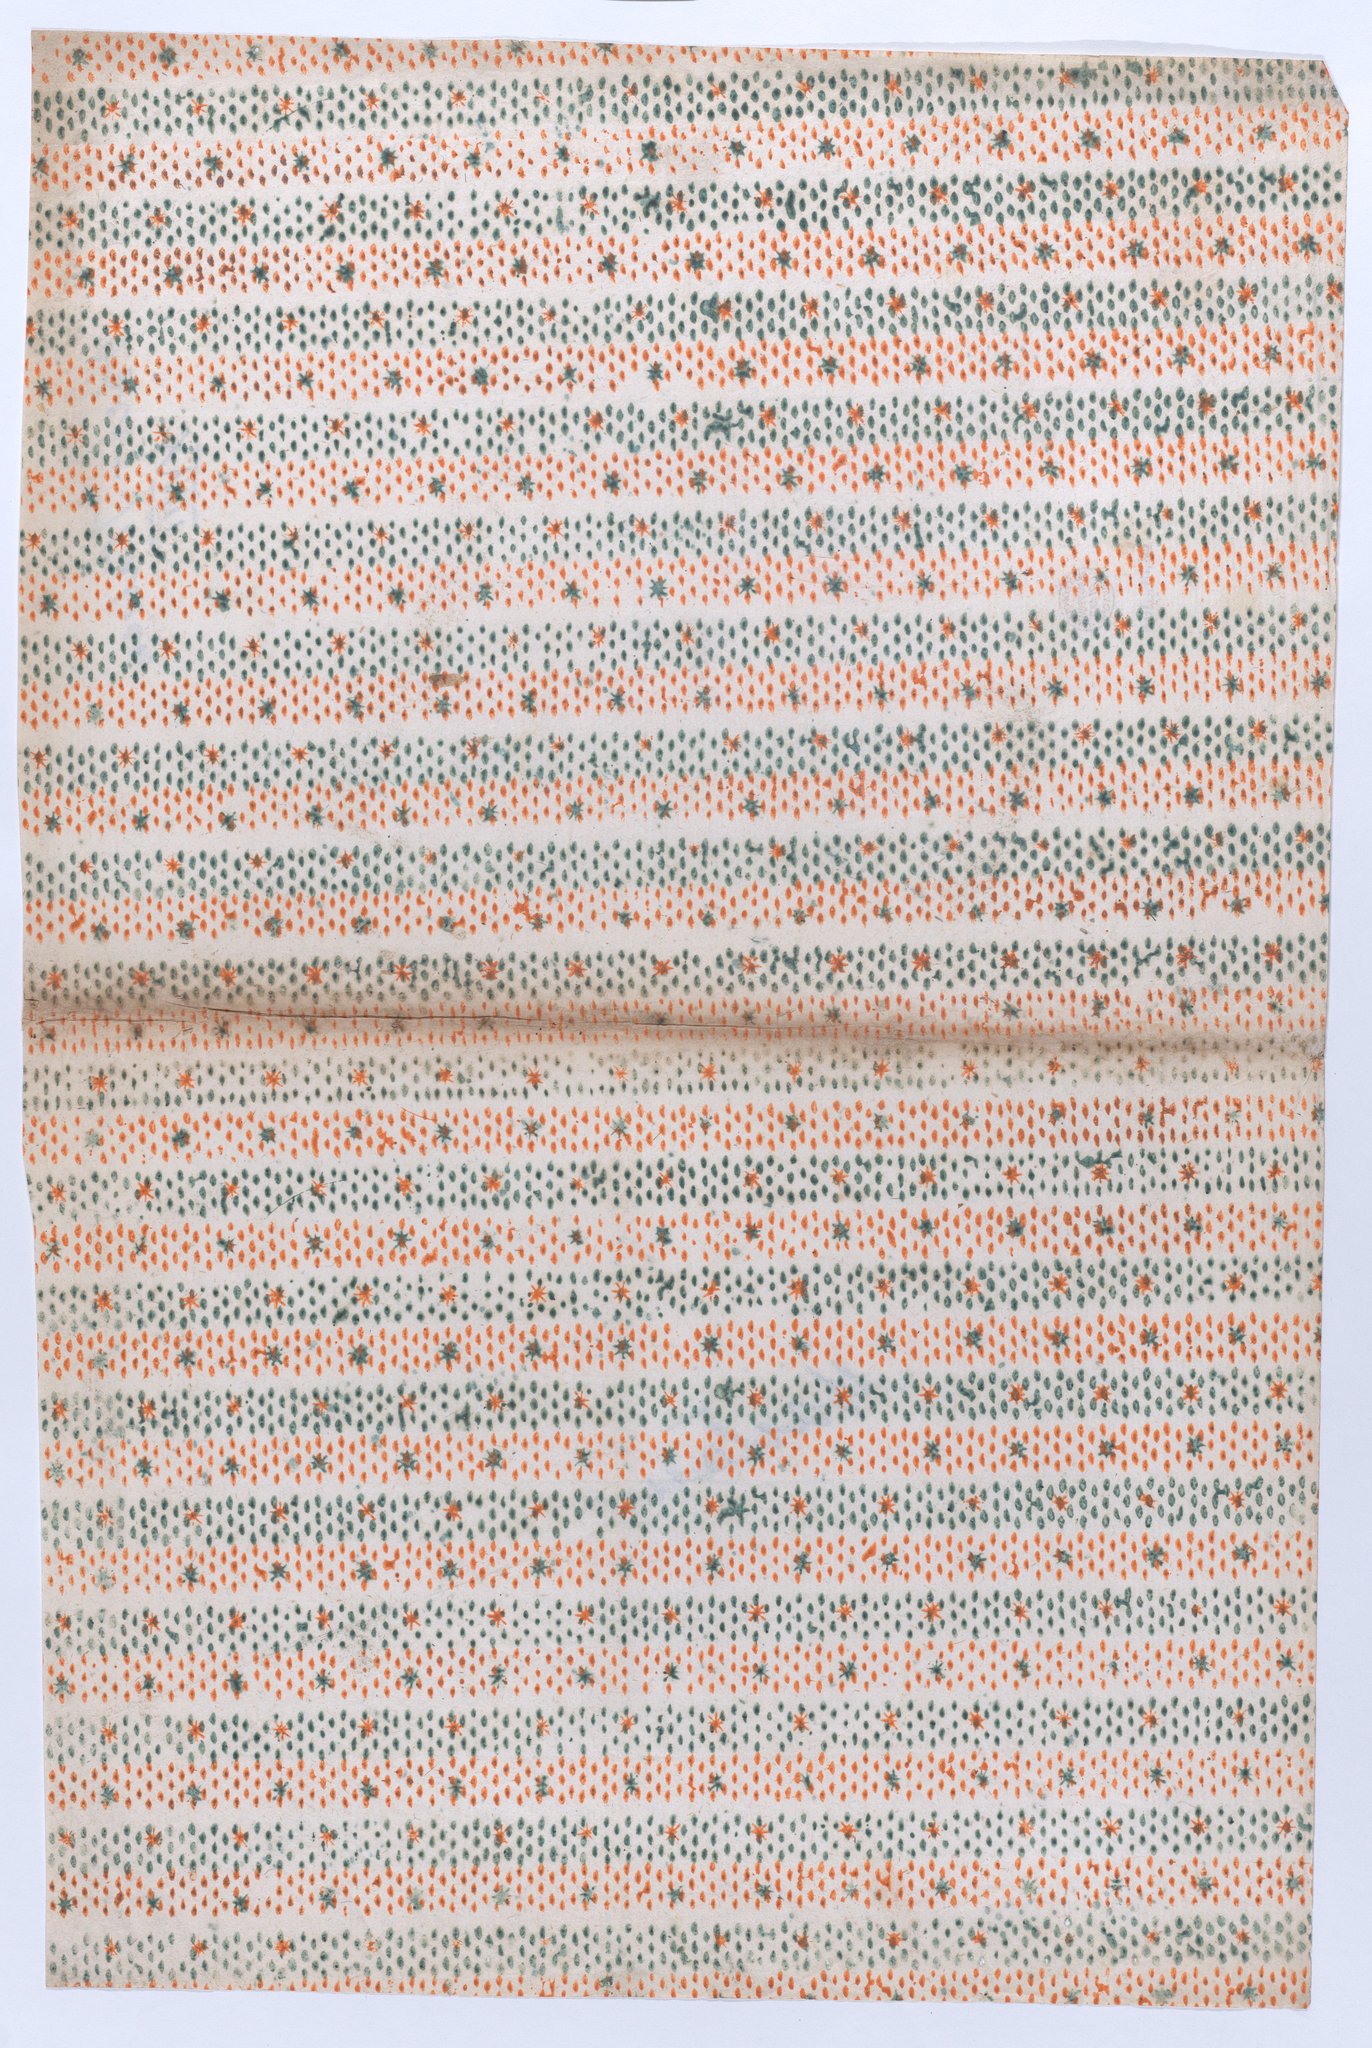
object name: print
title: Book cover with overall orange and green dot pattern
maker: Anonymous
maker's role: artist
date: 1801-1900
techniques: relief print